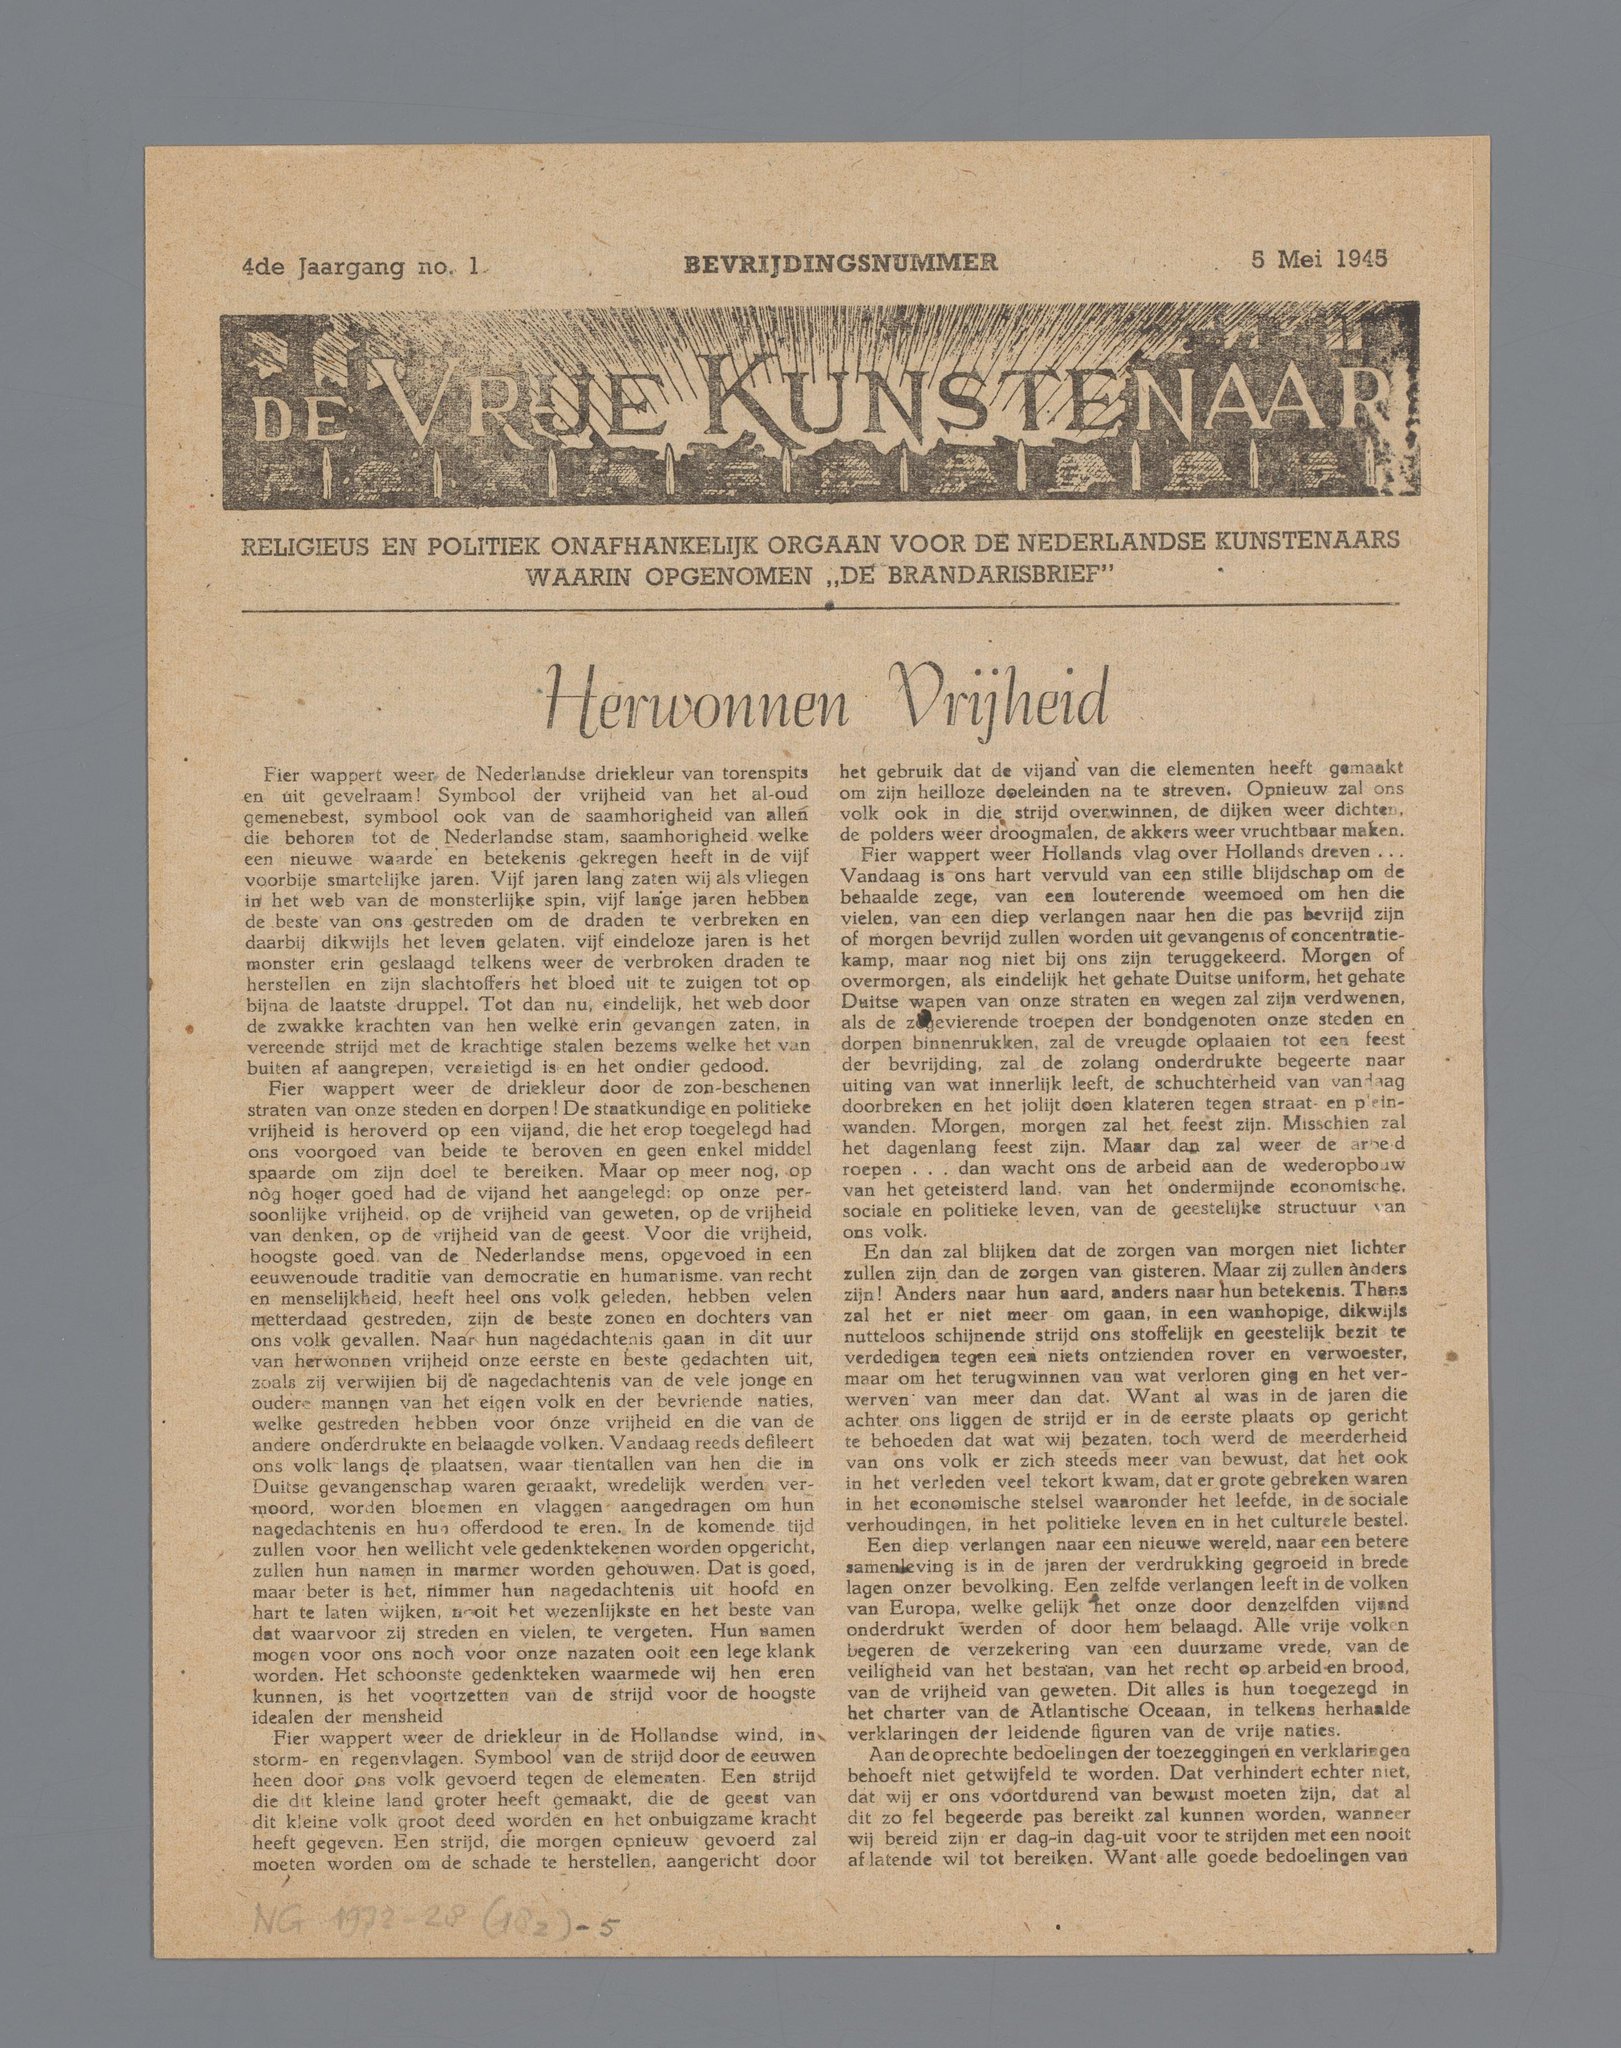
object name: magazine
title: De Vrije Kunstenaar; religieus en politiek onafhankelijk orgaan voor de Nederlandsche Kunstenaars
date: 1945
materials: paper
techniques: printing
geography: amsterdam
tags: netherlands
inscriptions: date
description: Nummer van 'De Vrije Kunstenaar', 4 genummerde pp (4de jaar, nr. 1). Opschrift: 'Herwonnen vrijheid'. Gedateerd: 5 mei 1945.